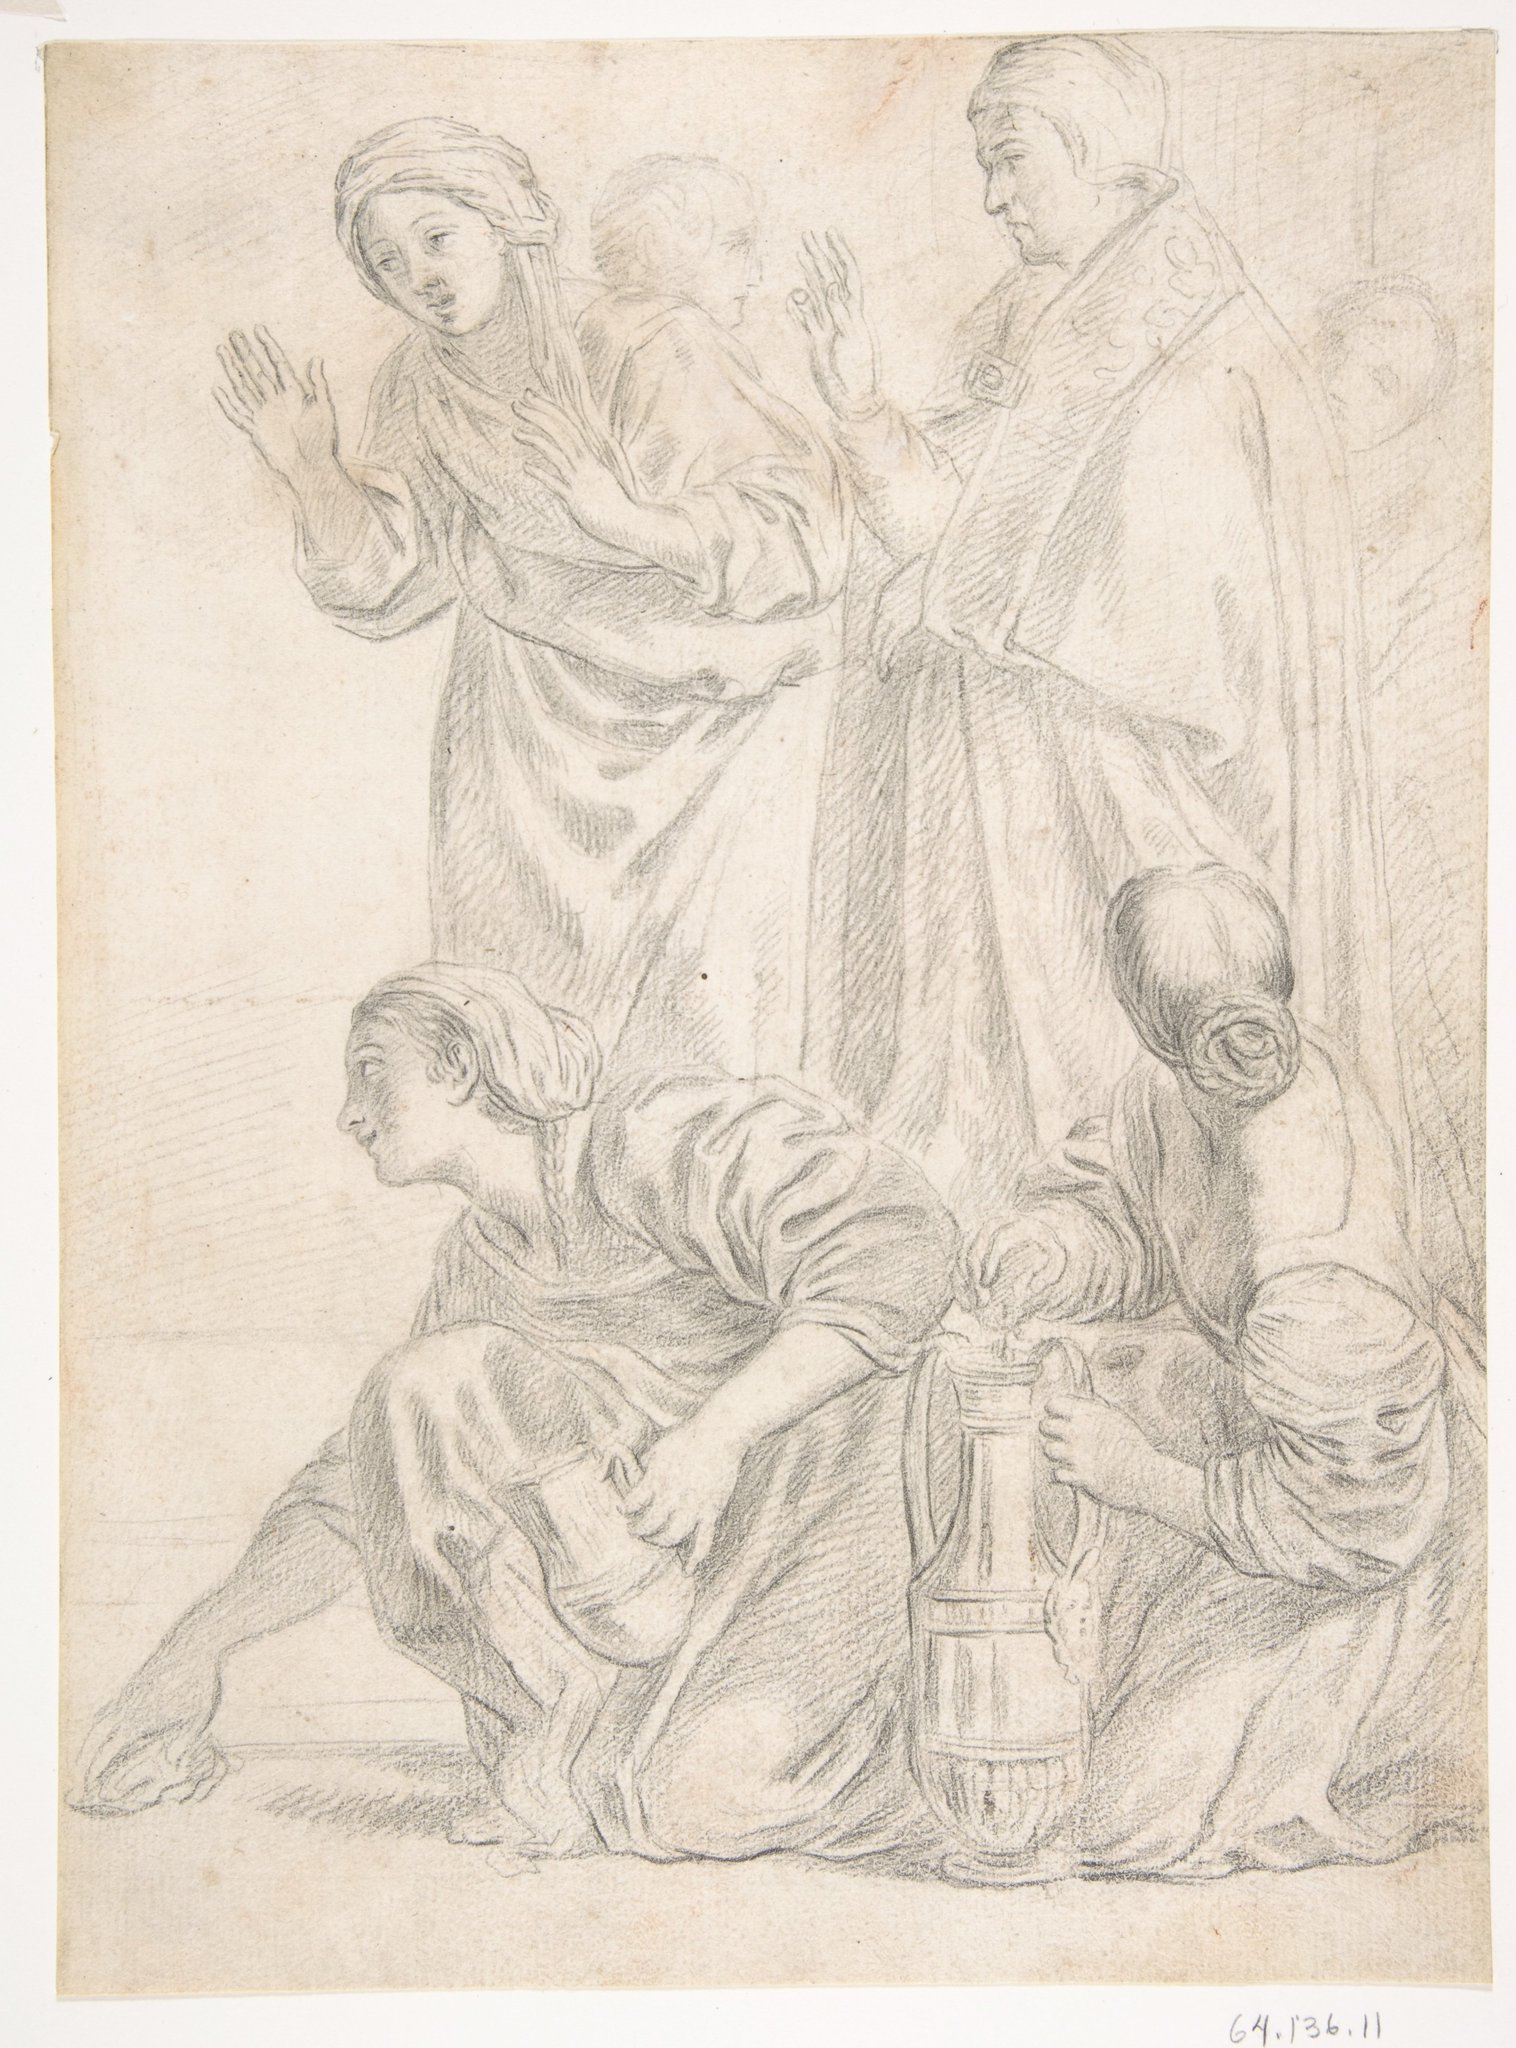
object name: drawing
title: Portion of the Martyrdom of Saint Cecilia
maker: domenichino (domenico zampieri)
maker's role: artist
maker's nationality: italian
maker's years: 1581-1641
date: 1581-1641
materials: chalk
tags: men,women,saints